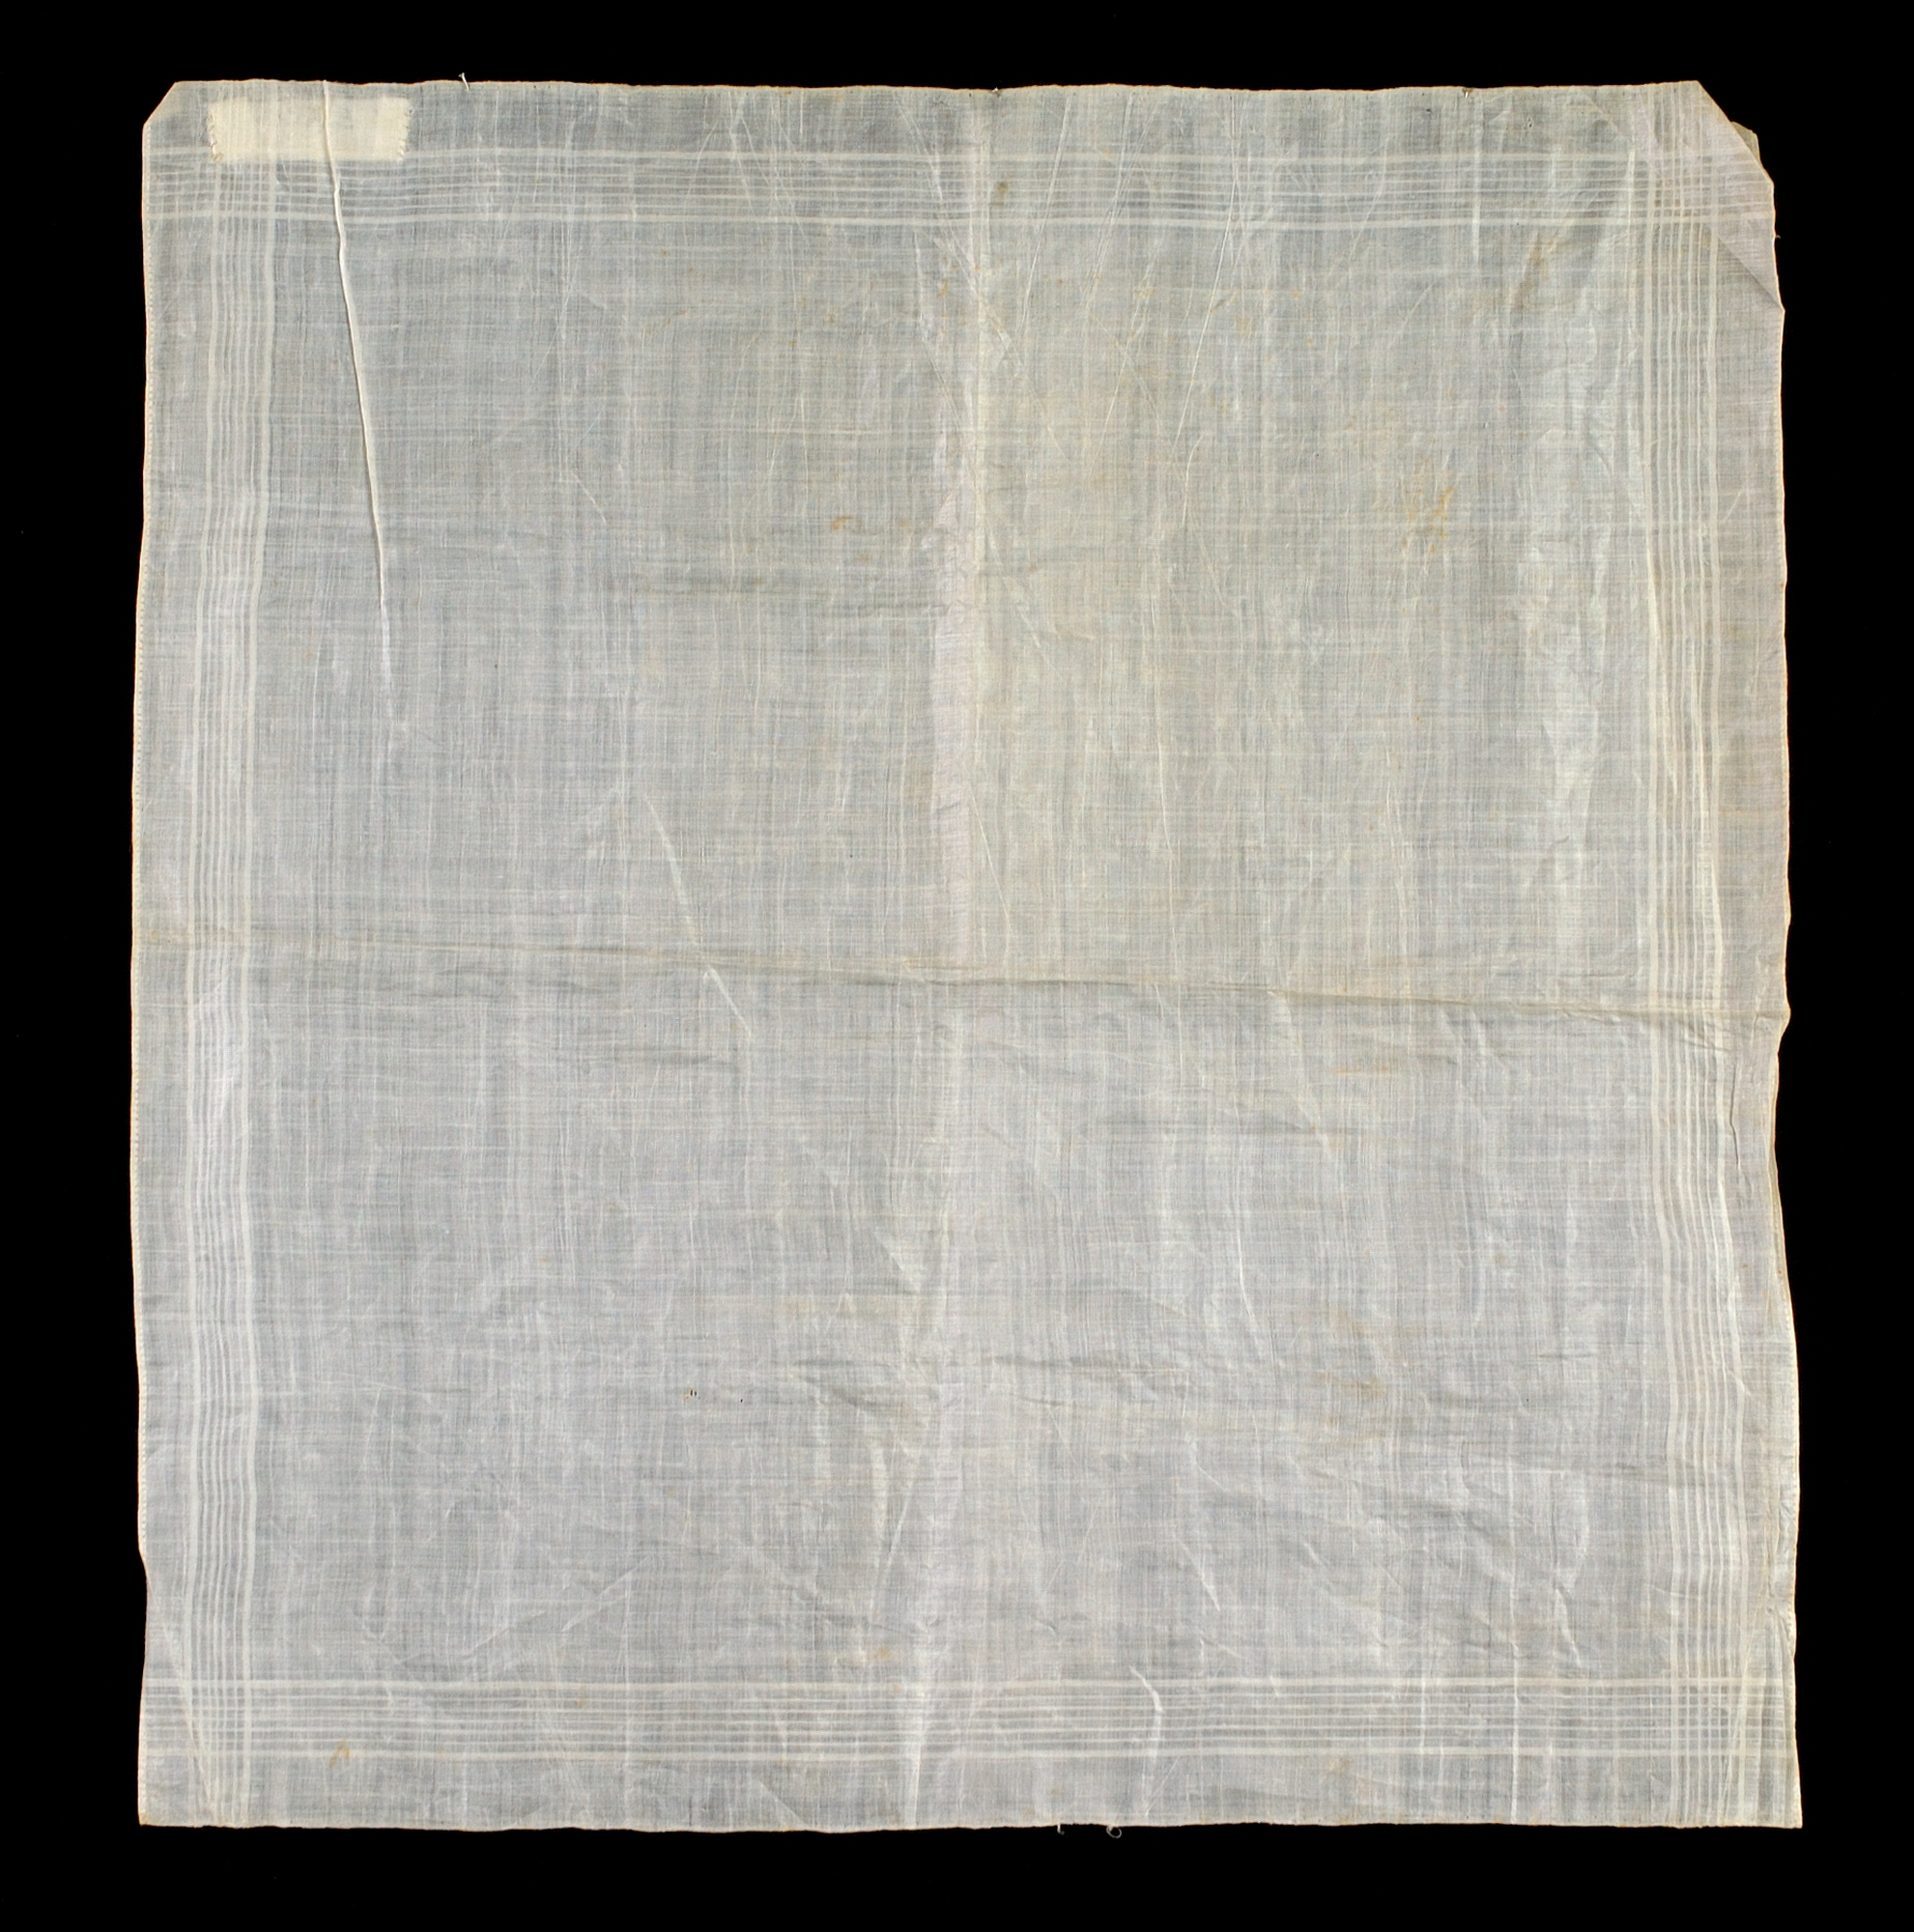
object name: handkerchief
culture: american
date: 1840-1860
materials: linen